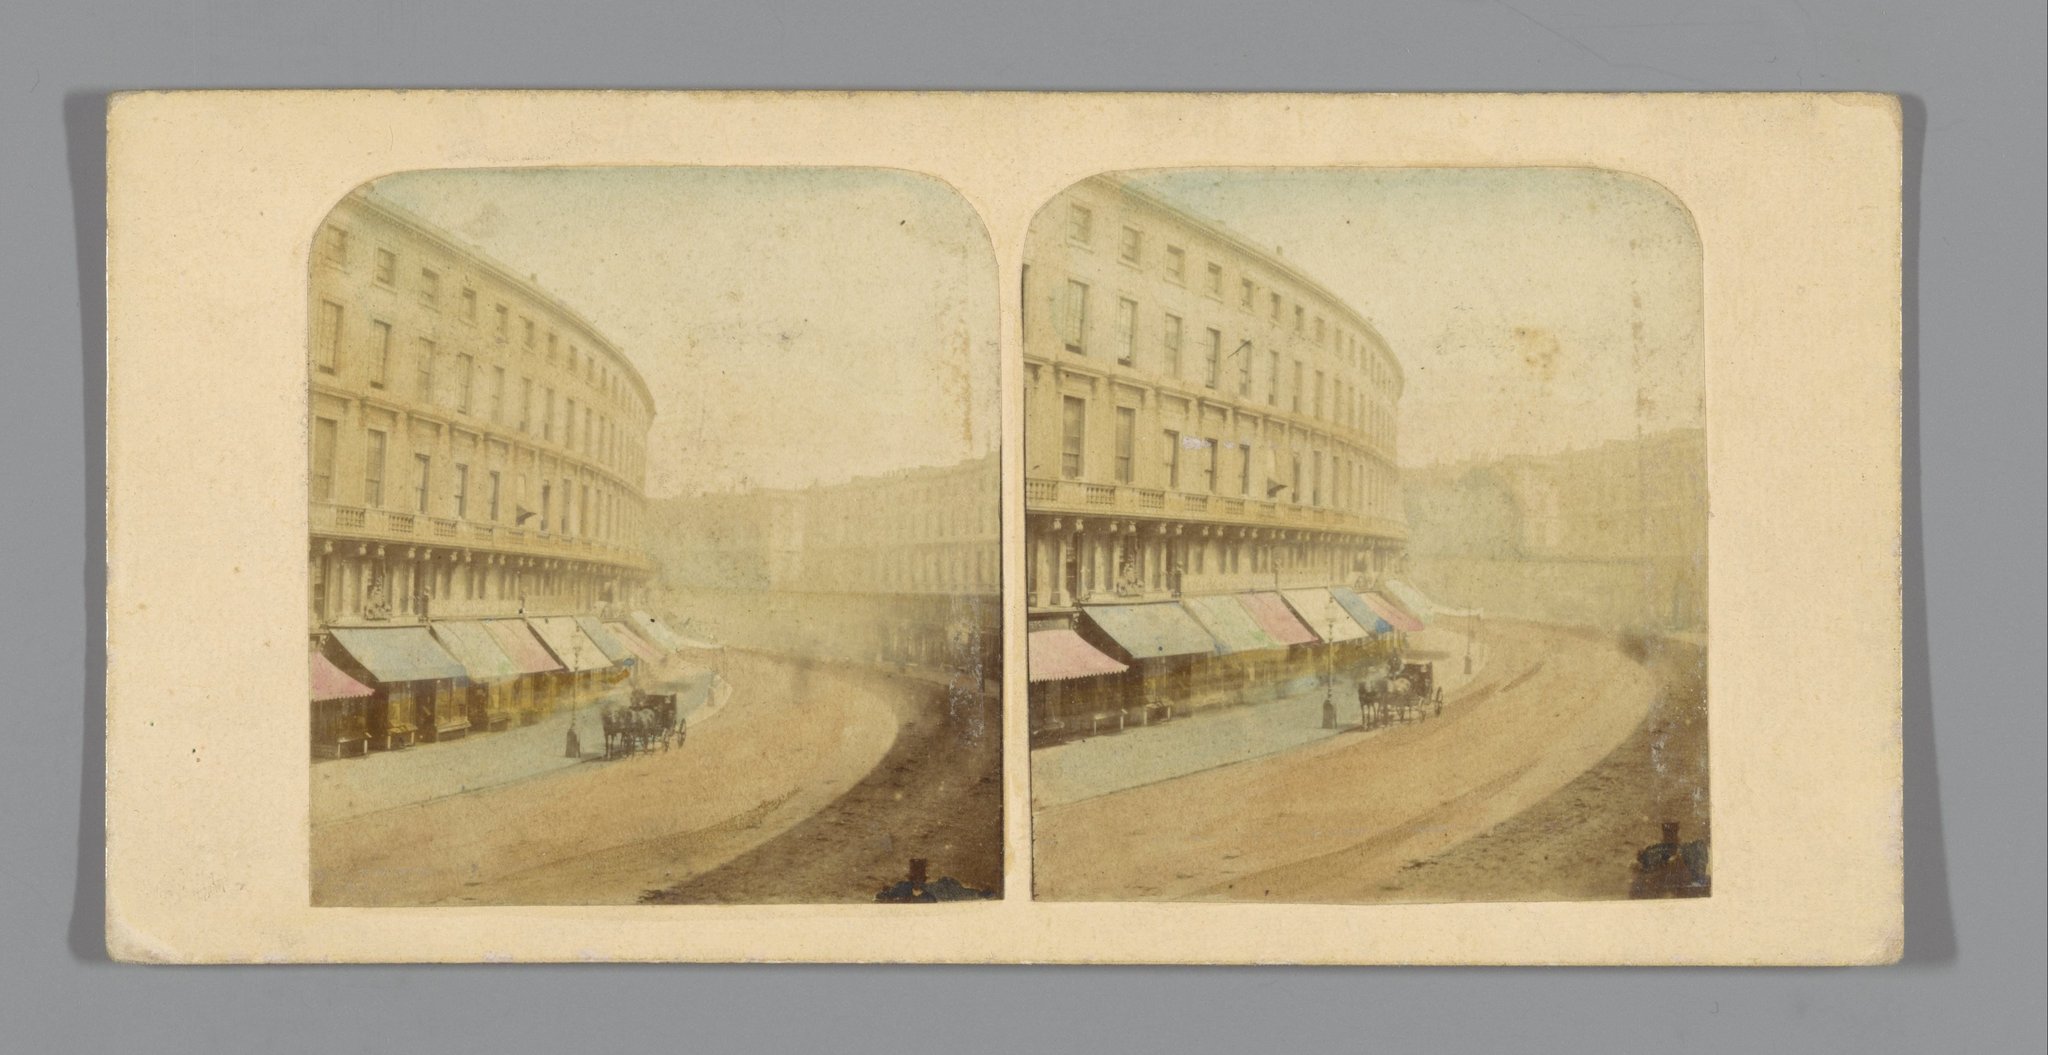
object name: stereograph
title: Gezicht op Regent Street in Londen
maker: Anonymous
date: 1850-1880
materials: cardboard, photographic support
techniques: albumen print, hand coloring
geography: regent street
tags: street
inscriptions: inscription: ‘vd. B. 1863. O.J.’, number: ‘46.’